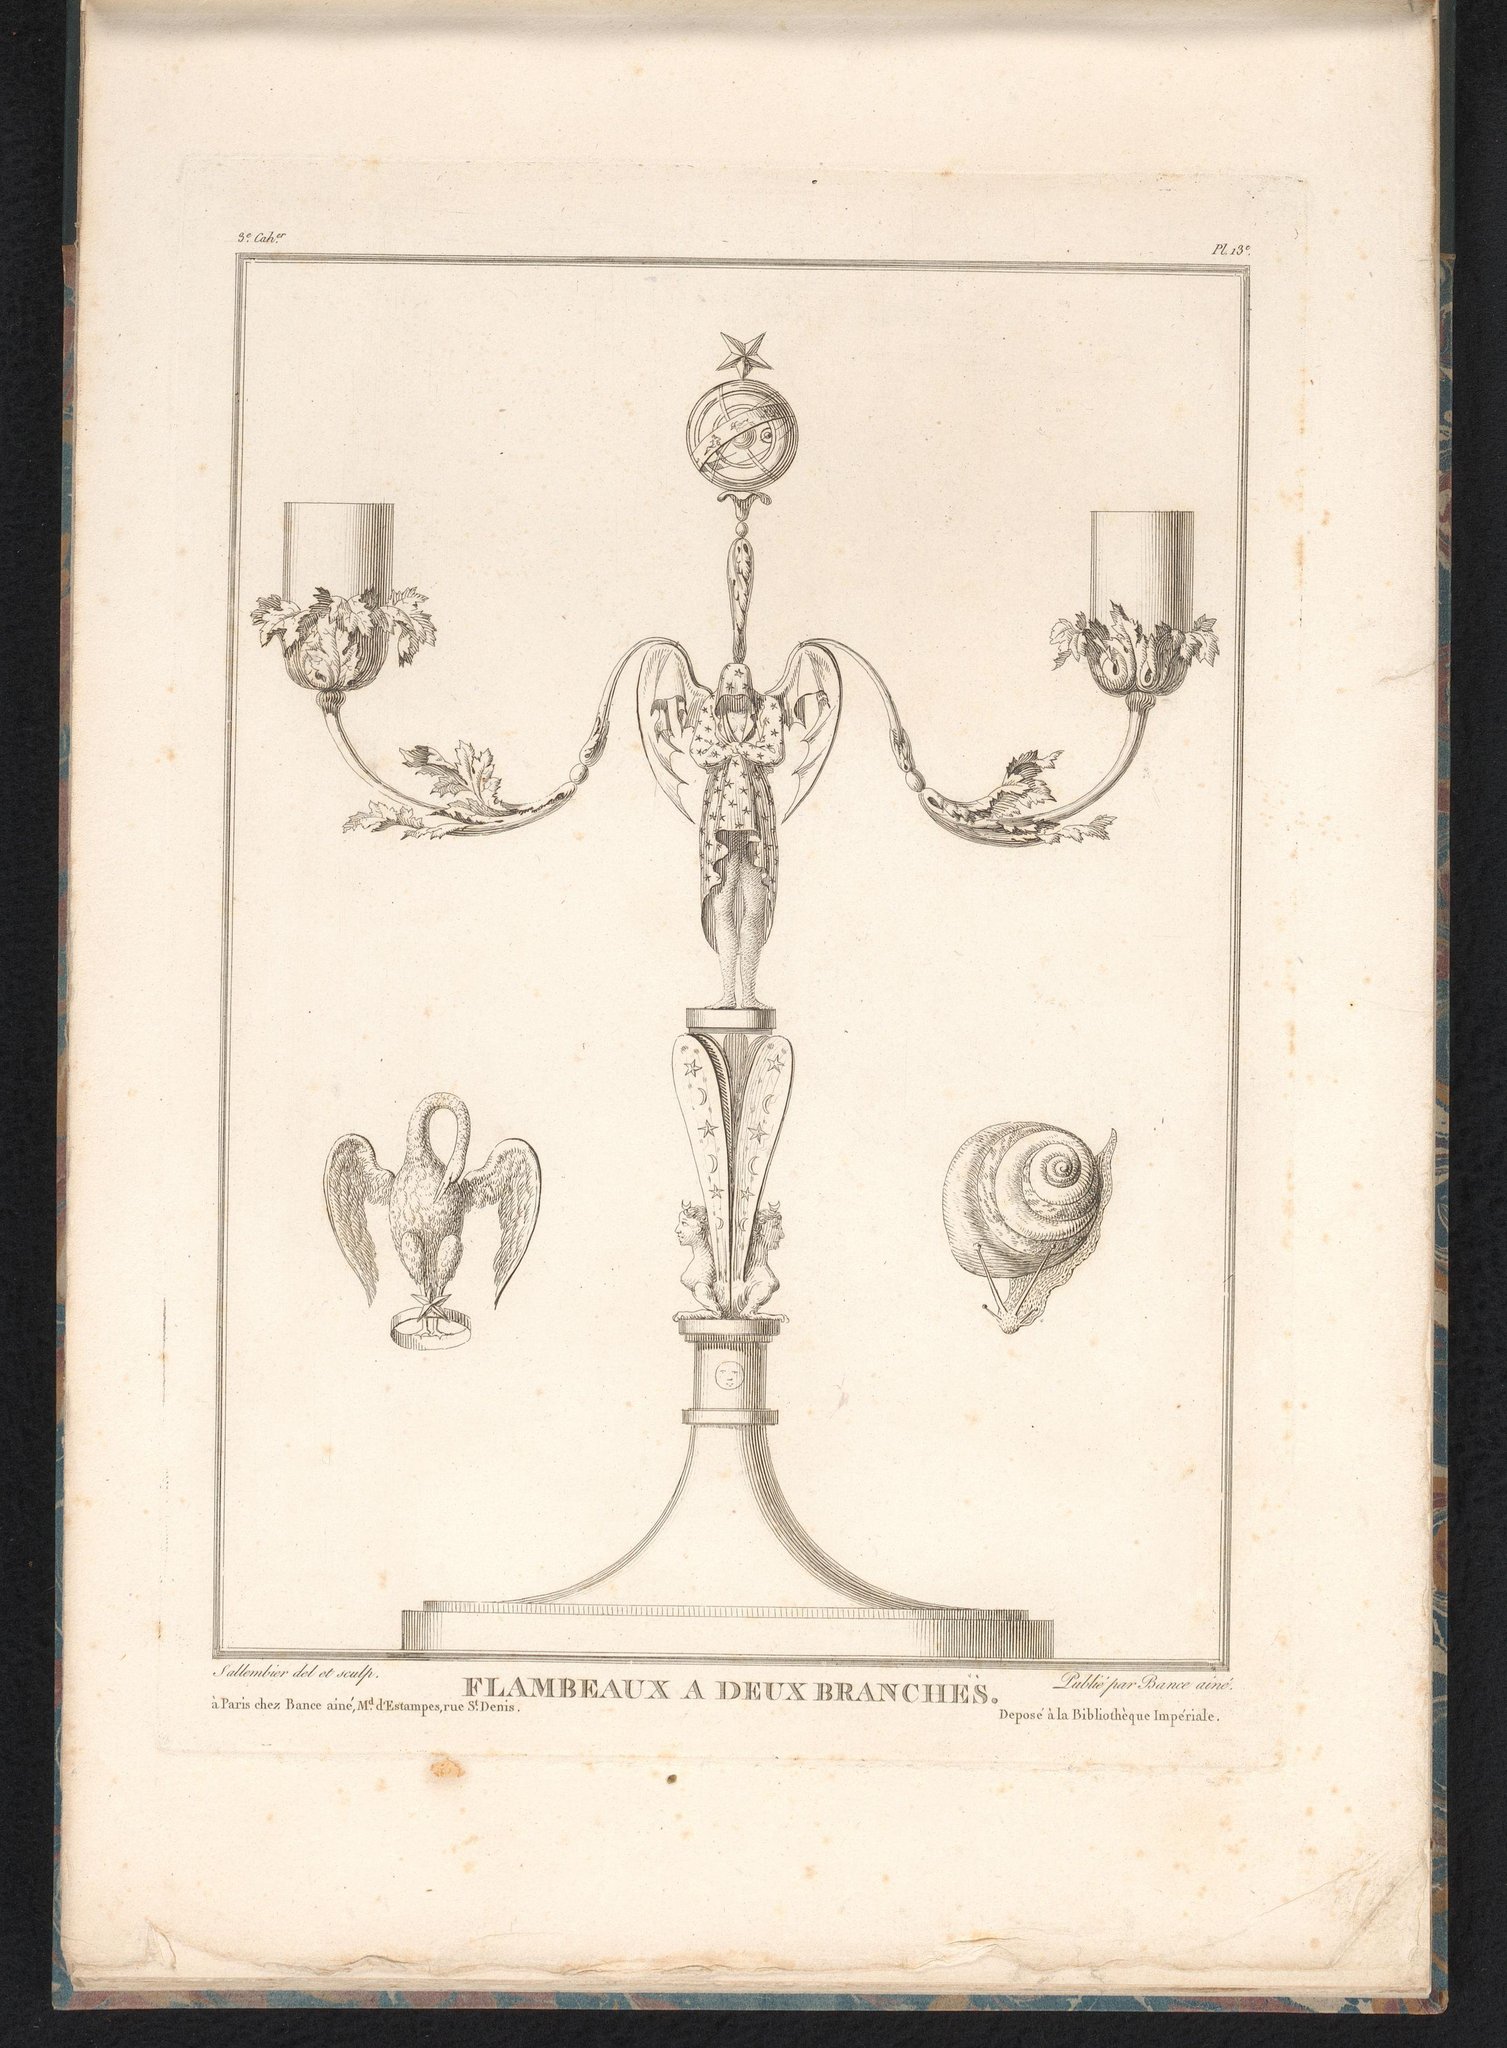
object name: ornament print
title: Modèles d'Orfèvrerie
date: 1805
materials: paper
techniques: etching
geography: paris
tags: chandelier, candelabrum, personification of the night, 'nox'; 'notte', 'carro della notte', 'serenità della notte' (ripa), molluscs: snail, water-birds: pelican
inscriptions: number: ‘3.e Cah.er’, : ‘Déposé à la Bibliothèque Impériale’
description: Ontwerpen voor kandelaar met een gevleugelde figuur, mogelijk een personificatie van de nacht. Ernaast een ornament van een pelikaan en een slak. Prent maakt deel uit van een album.